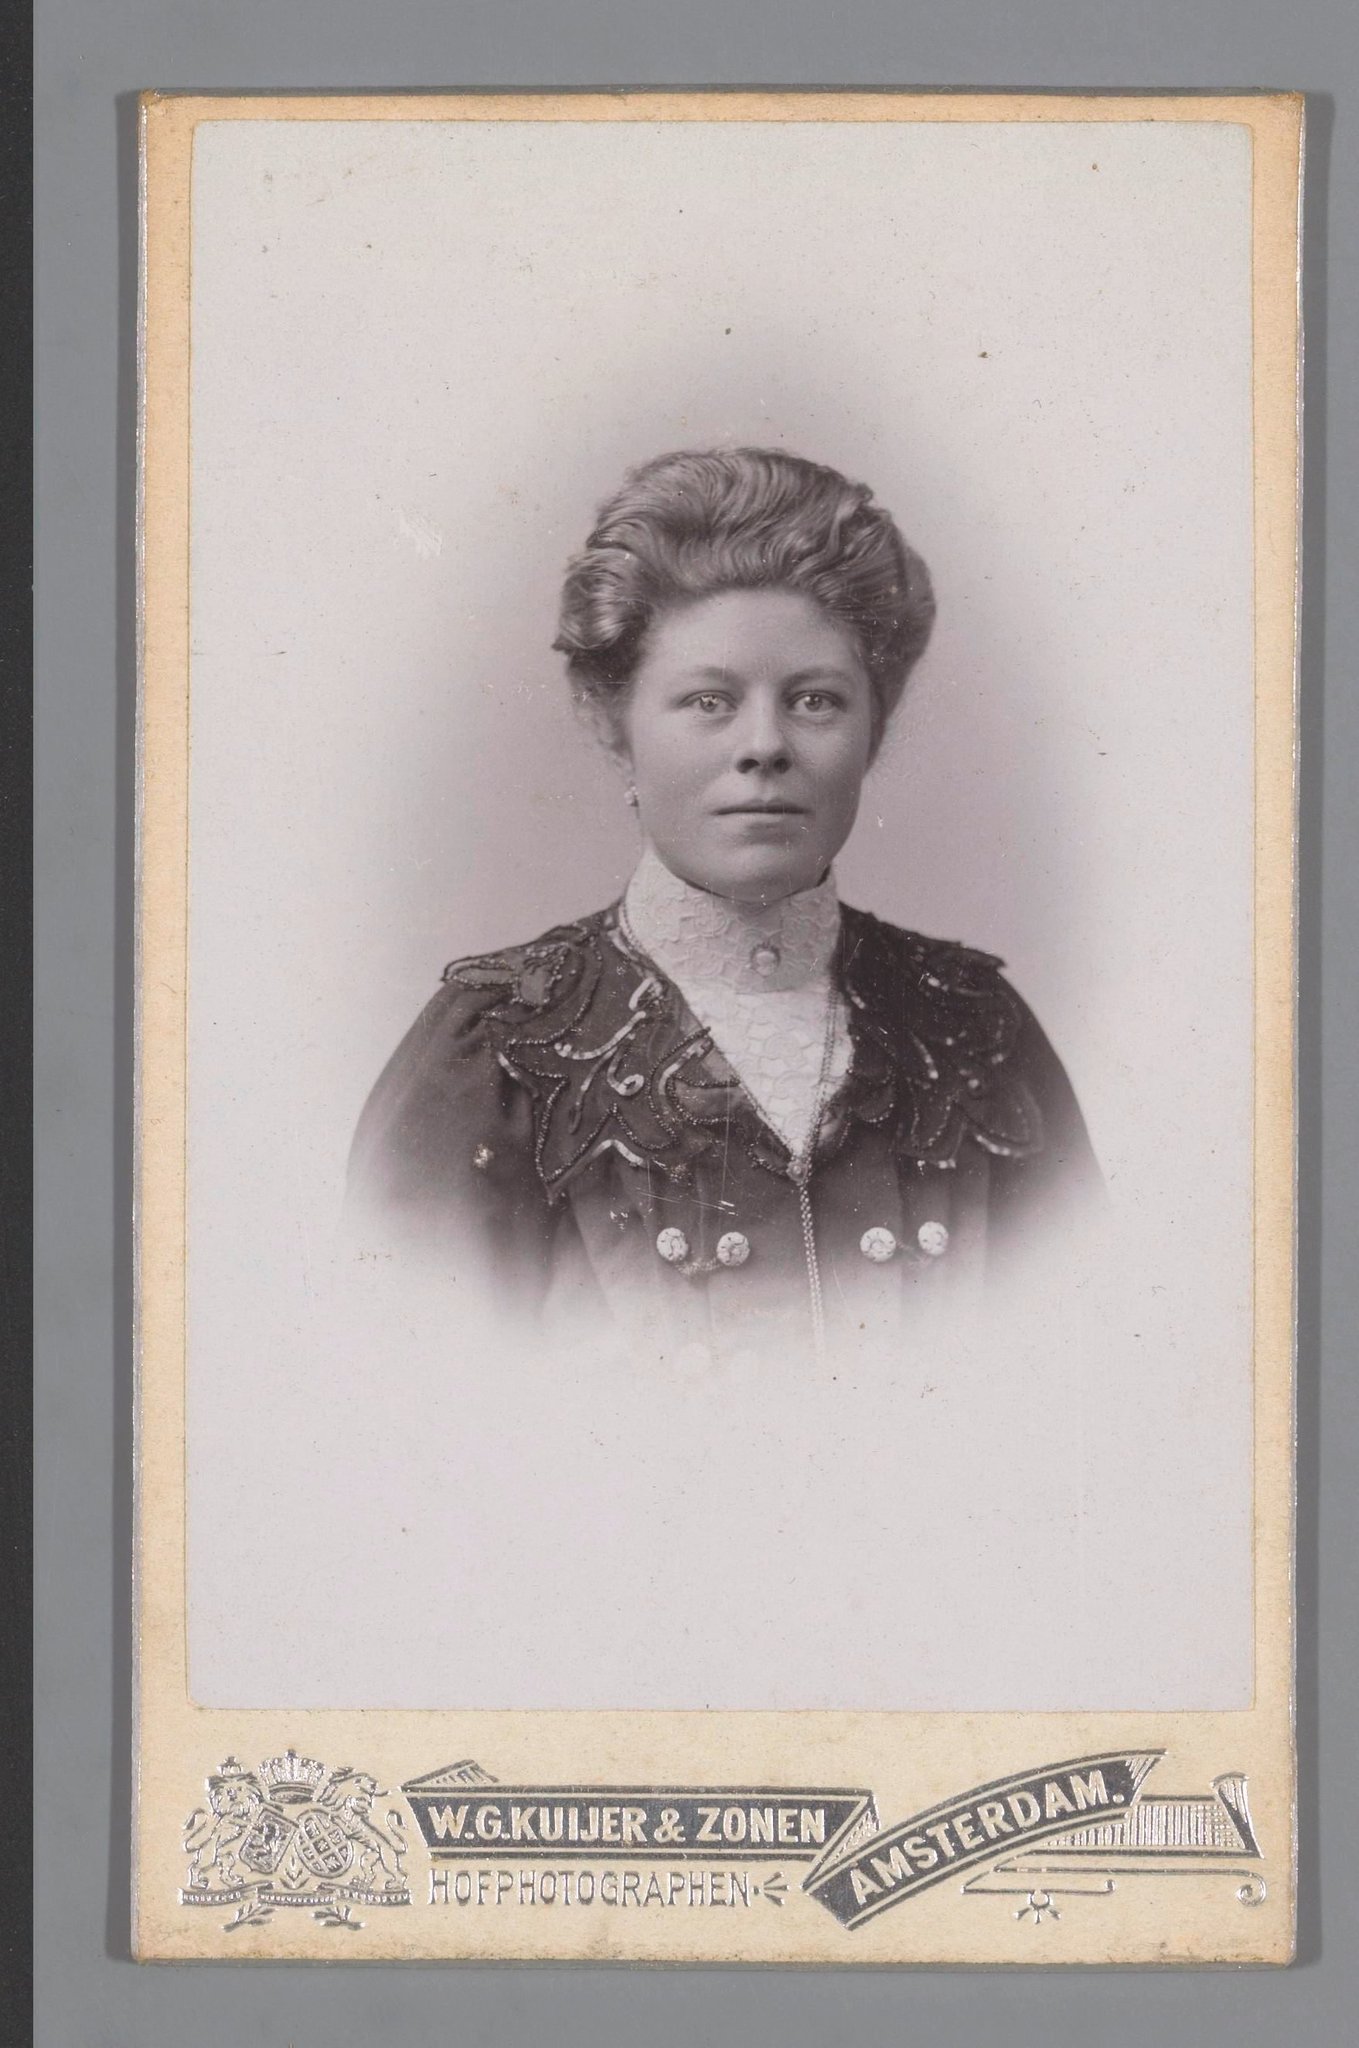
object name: carte de visite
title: Portret van een onbekende vrouw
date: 1885-1928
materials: cardboard, paper, photographic support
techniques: collodion silver print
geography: amsterdam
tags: adult woman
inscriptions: name: ‘W.G. Kuijer & Zonen Hofphotographen Amsterdam’, inscription: ‘Opgericht 1864 W.G. Kuijer & Zonen Hofphotographen Westermarkt 19 Amsterdam 13 Spéciale Inrichting voor Vergrootingen in alle Formaten.’